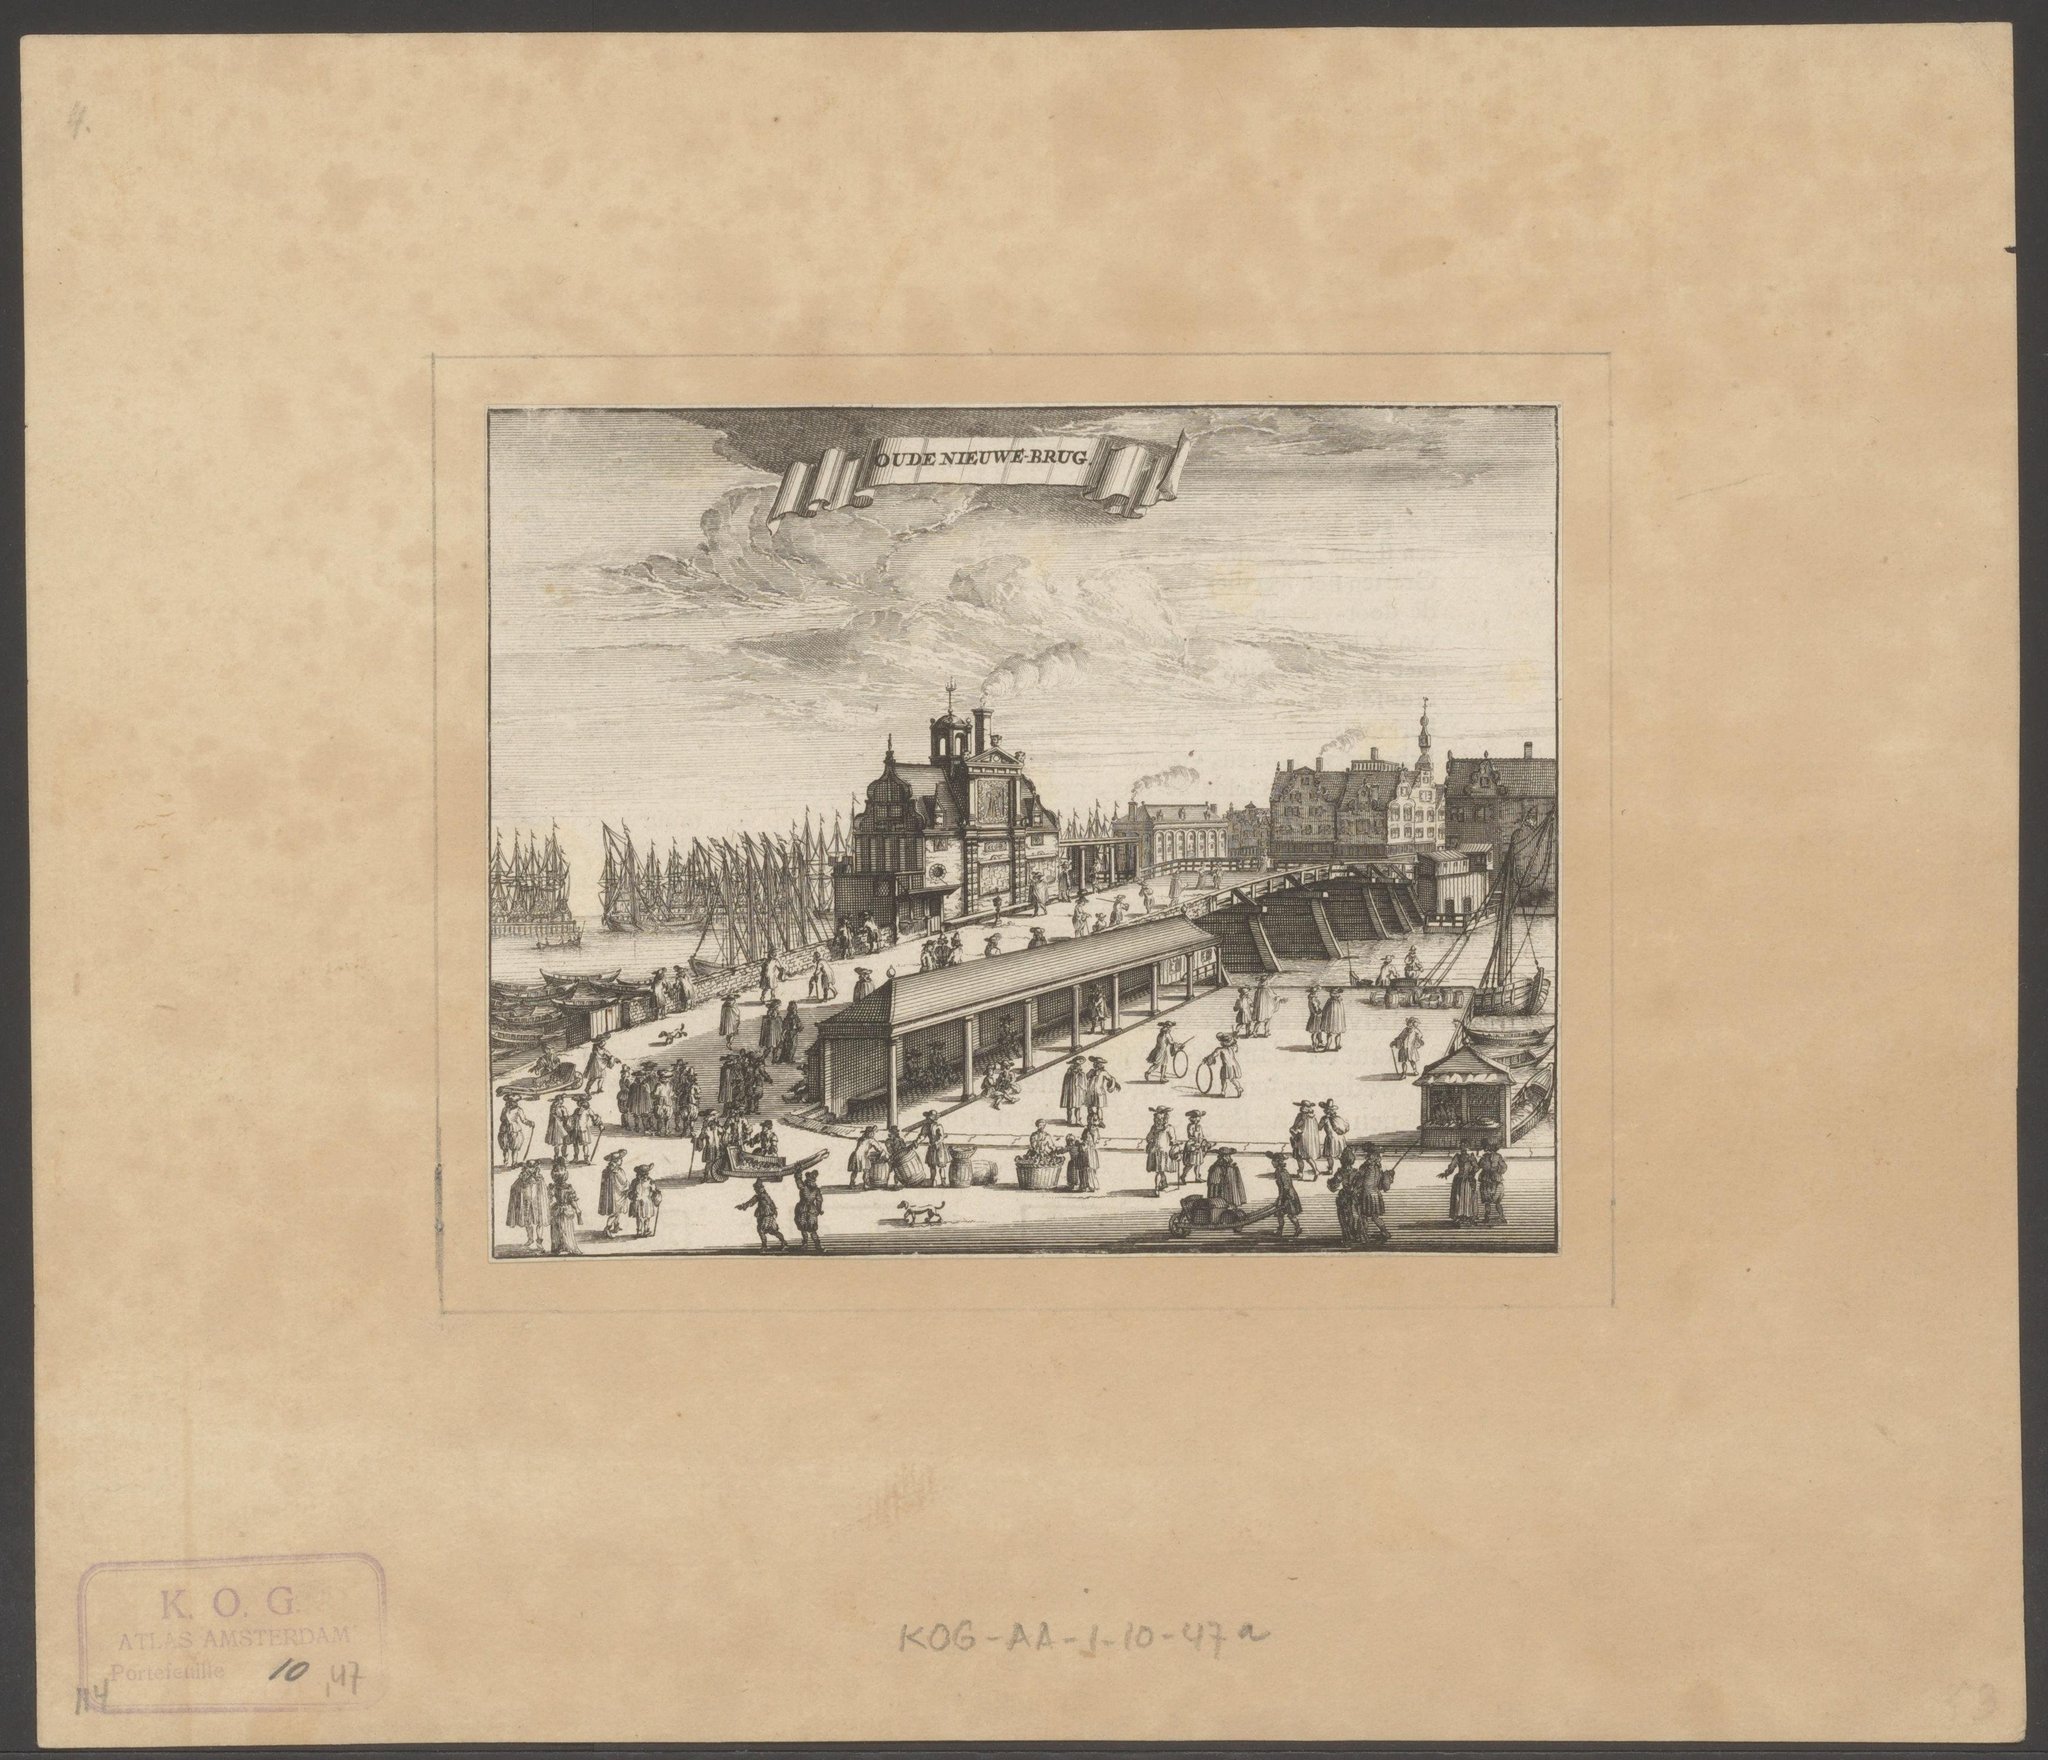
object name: print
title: Gezicht op het Paalhuis en de Nieuwe Brug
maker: Anonymous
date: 1693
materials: paper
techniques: engraving, etching, letterpress printing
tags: city-view in general; 'veduta', canal, bridge in city across river, canal, etc., taxes and financial administration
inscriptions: collector's mark: ‘10,47’ Lugt 1641b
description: Prent uit: Commelin, Caspar. Beschryvinge van Amsterdam, desselfs eerste oorspronk uyt den Huyse (…). 2 delen. Amsterdam: Abraham Wolfgang, Gillis Janssonius van Waesberge, Johannes Janssonius van Waesberge II, weduwe Dirk Boom I, Hendrick Boom en Rembertus Goethals, 1693.